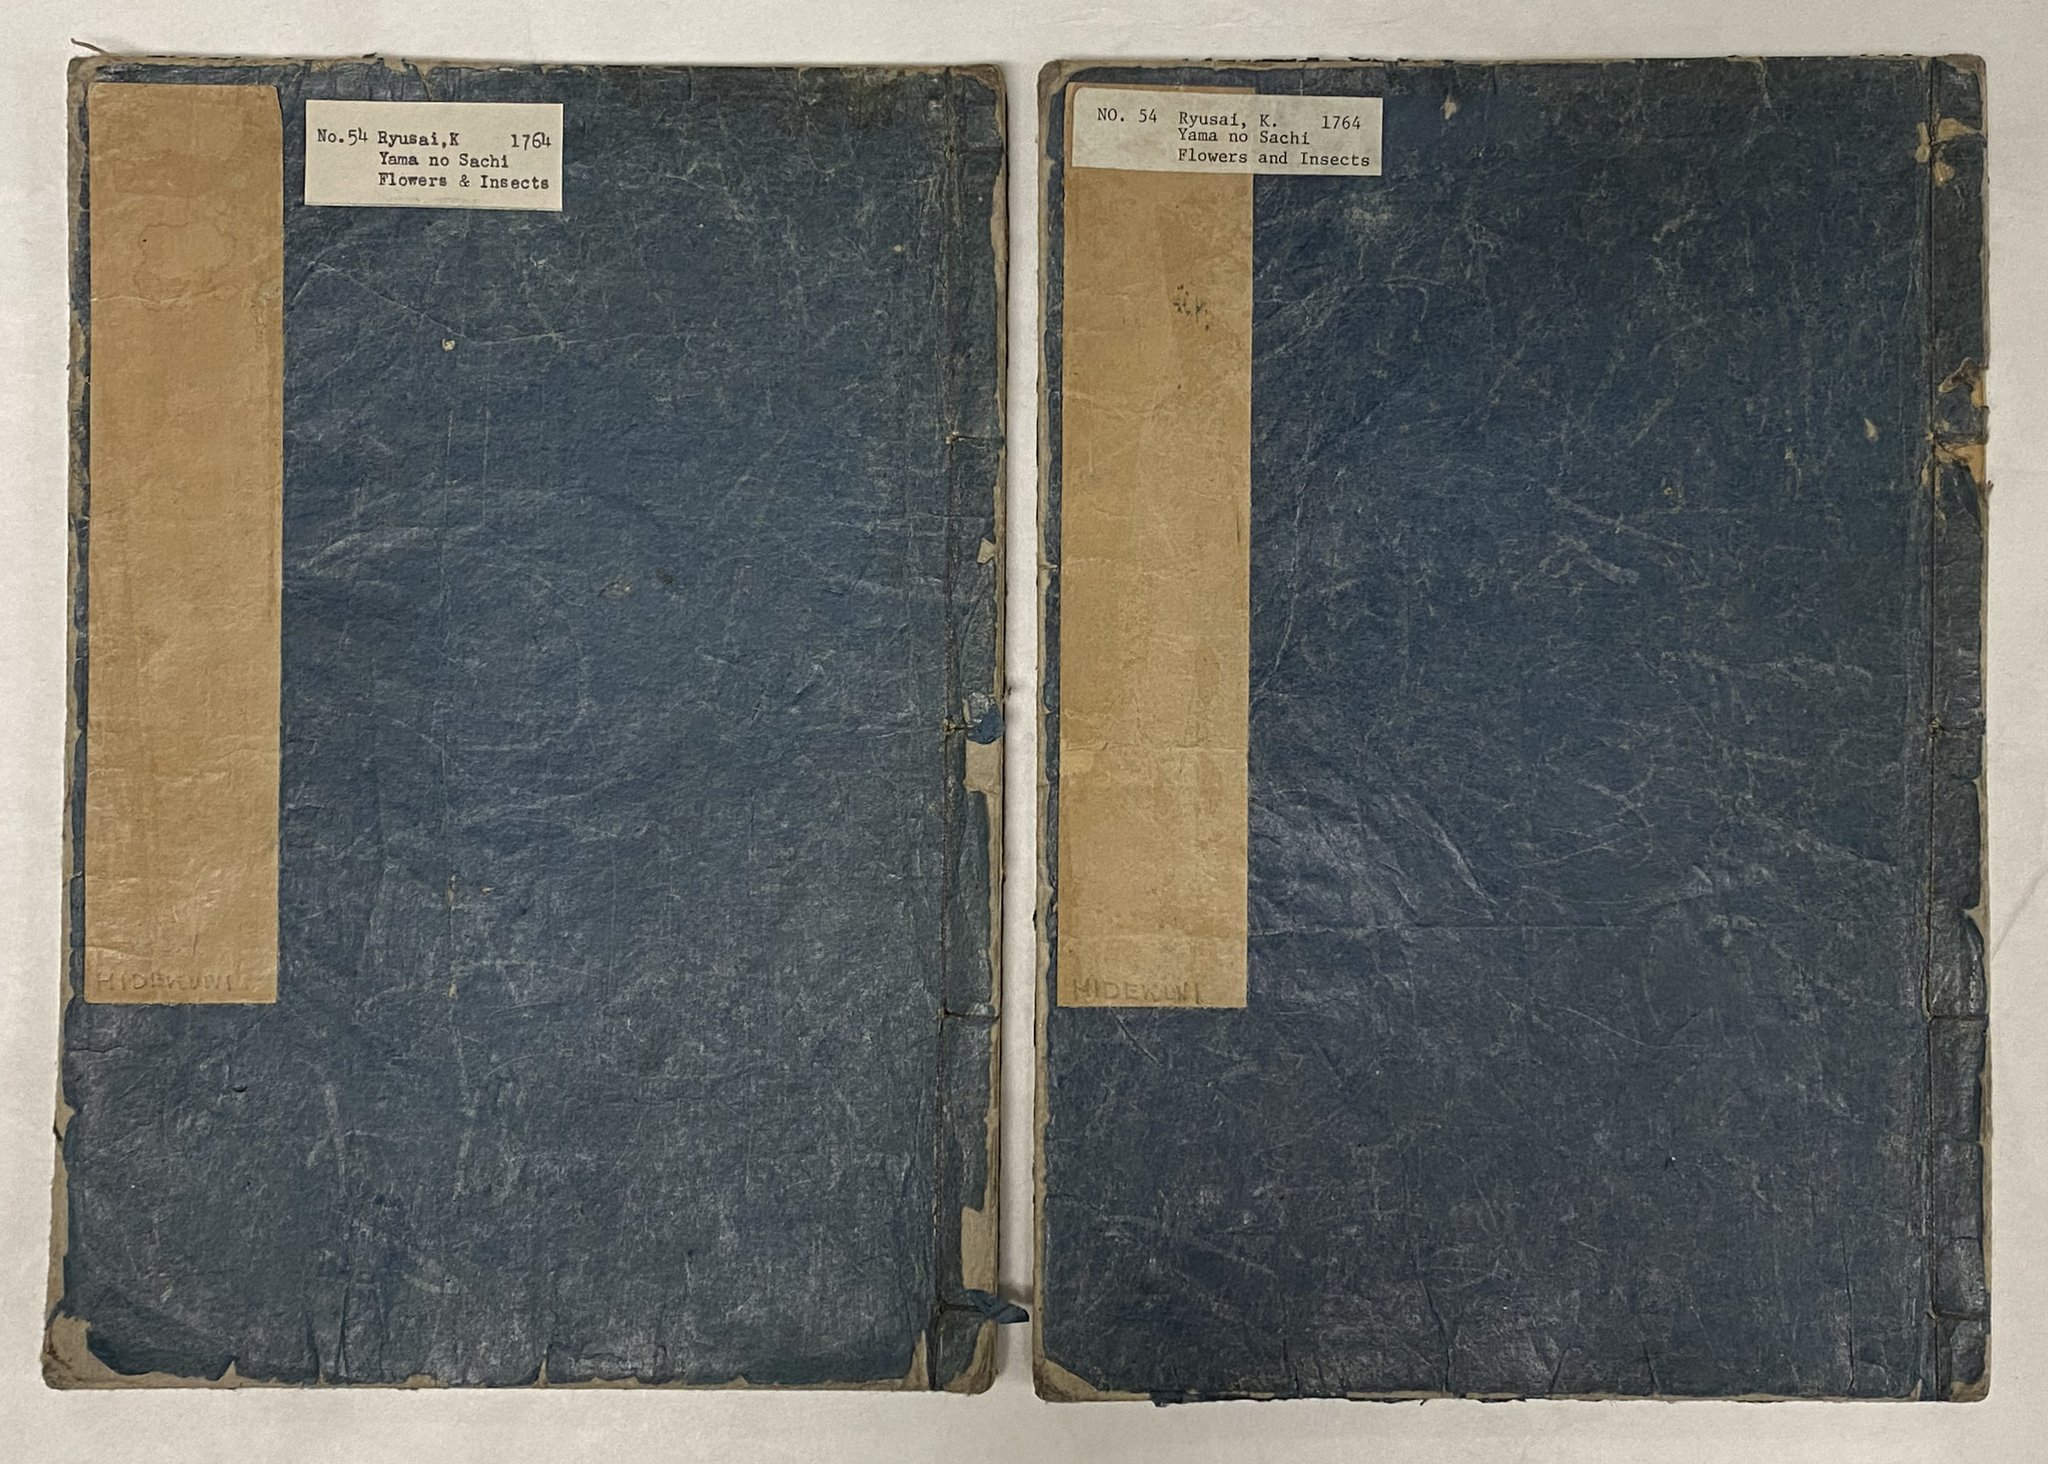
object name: illustrated book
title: The Abundance of the Mountains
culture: japanese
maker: katsuma ryūsai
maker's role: artist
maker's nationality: japanese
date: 1765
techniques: polychrome, woodblock print